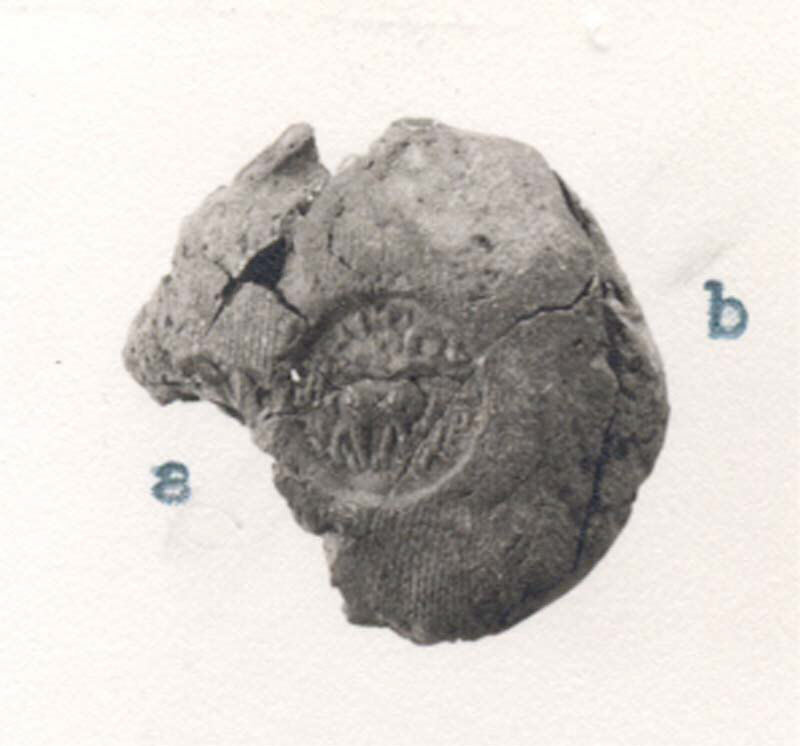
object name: sealing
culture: sasanian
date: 601-700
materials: clay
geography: iran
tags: animals